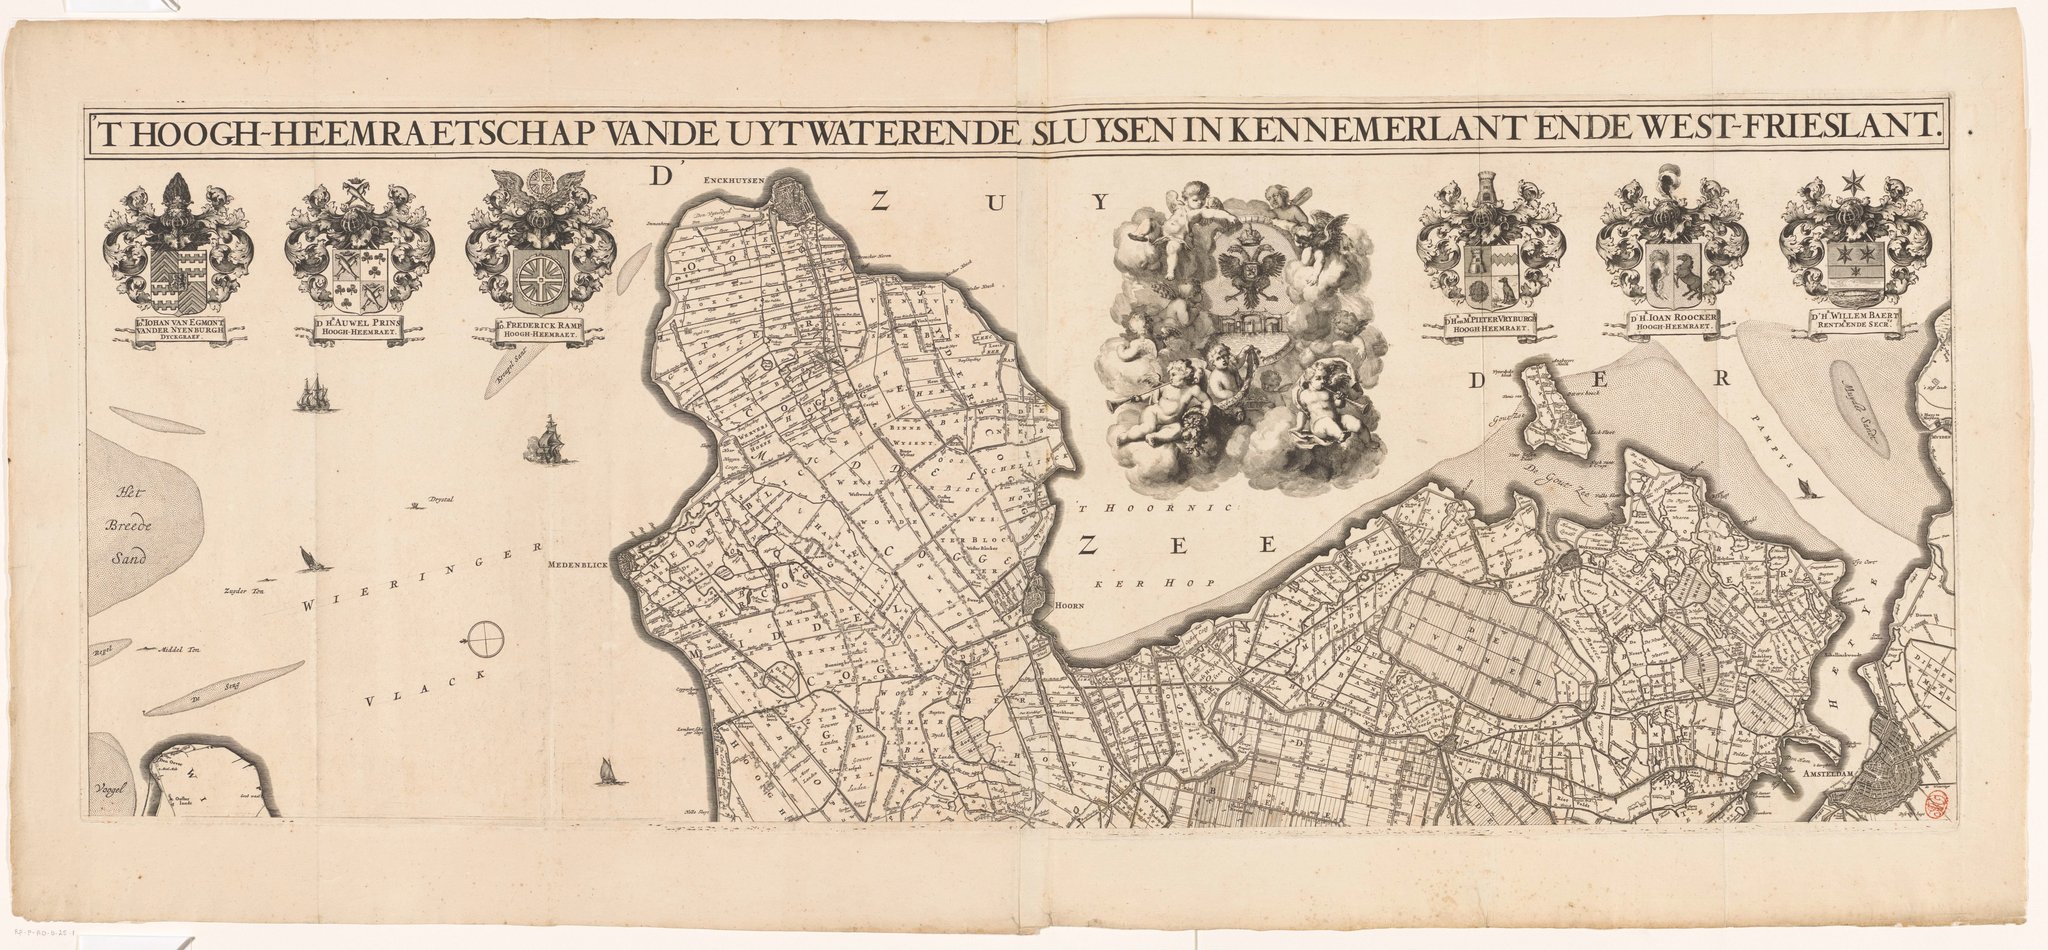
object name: print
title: 't Hoogh-heemraetschap vande Uytwaterende Sluysen in Kennemerlant ende West-Frieslant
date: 1680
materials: paper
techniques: engraving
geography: amsterdam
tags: coat of arms (as symbol of the state, etc.), maps of separate countries or regions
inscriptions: collector's mark: Lugt 195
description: Bovenste deel van een kaart van Kennemerland en West-Friesland.